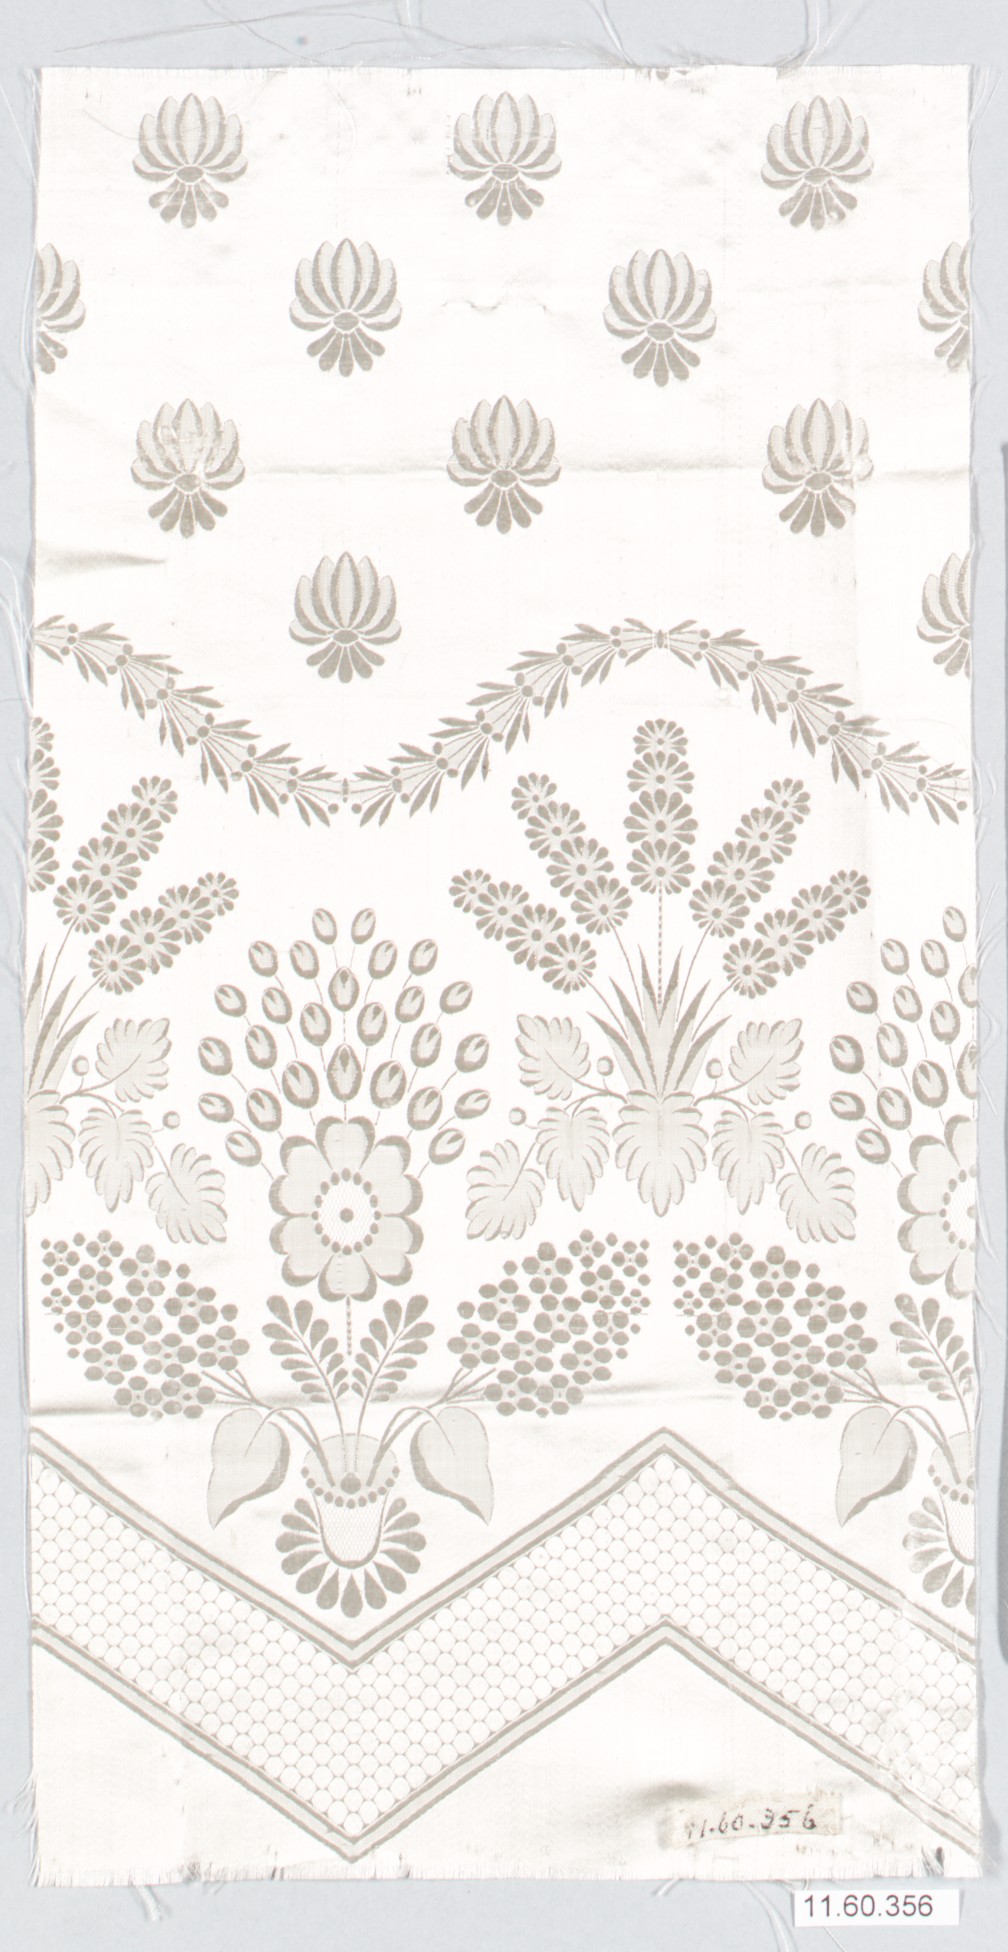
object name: fragment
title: Fragments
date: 1801-1900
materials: silk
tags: flowers,leaves